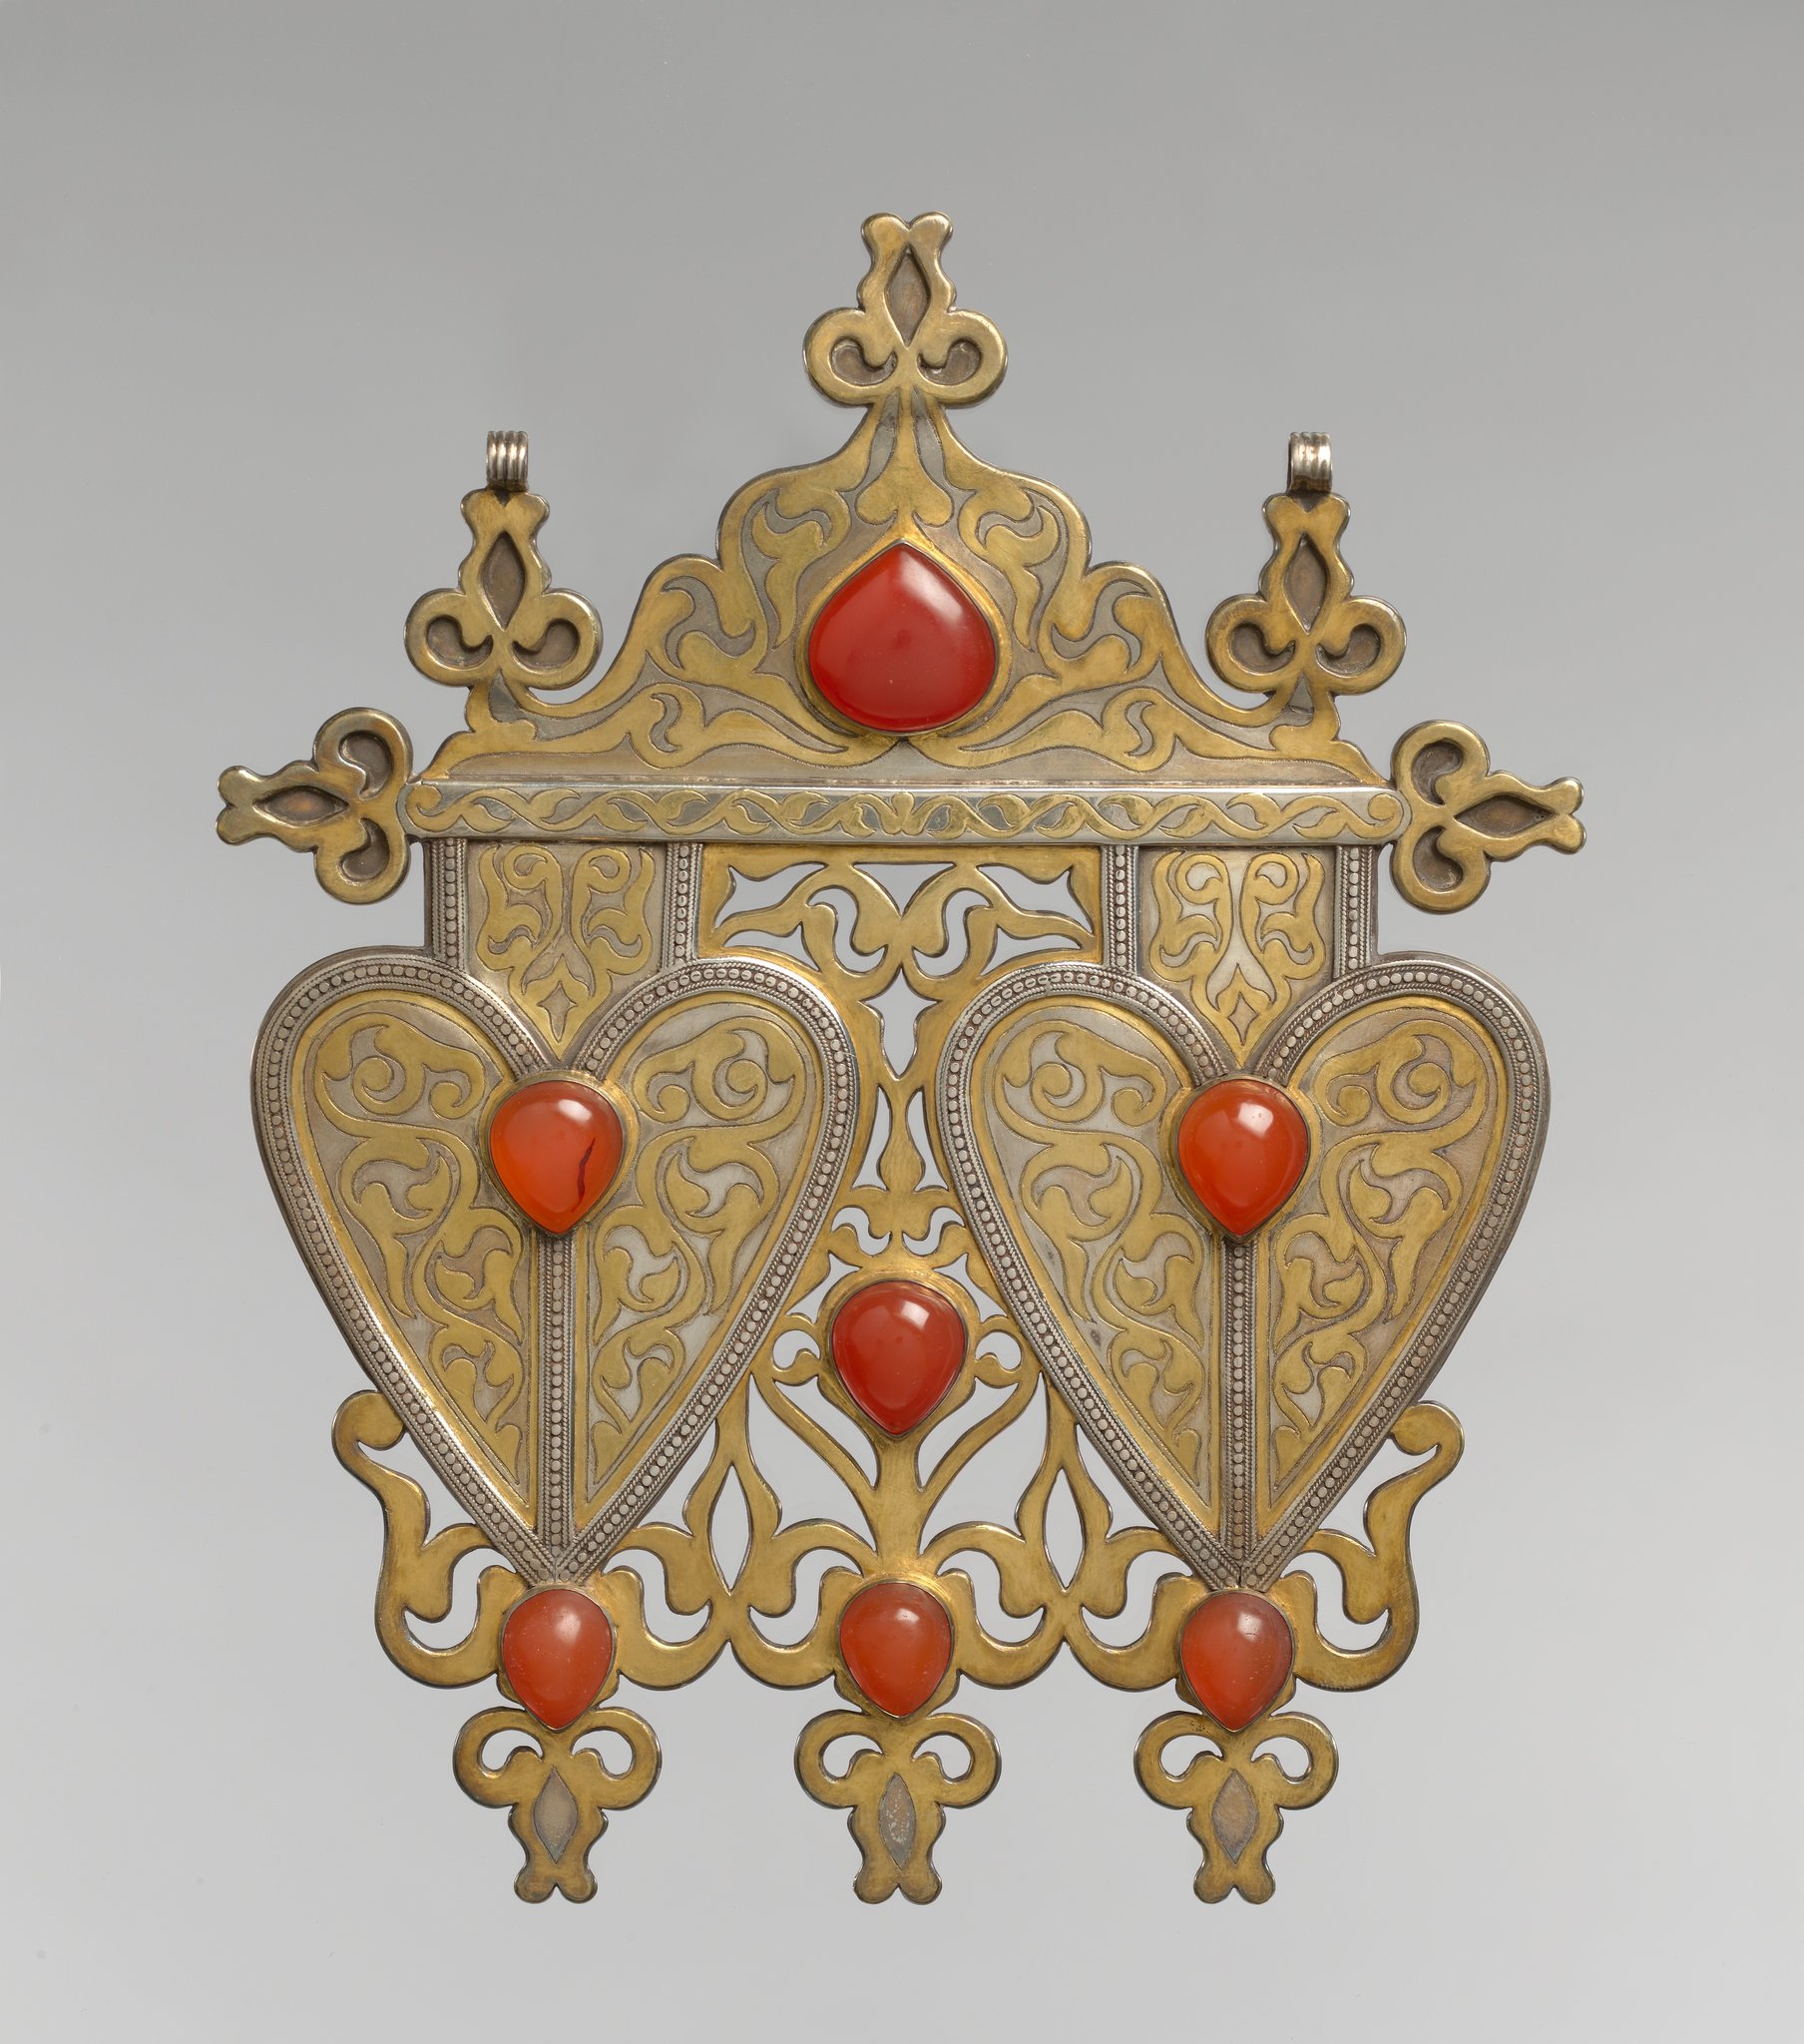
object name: ornament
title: Double Cordiform Pendant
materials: carnelian, silver, metal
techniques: chasing, gilding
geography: central asia